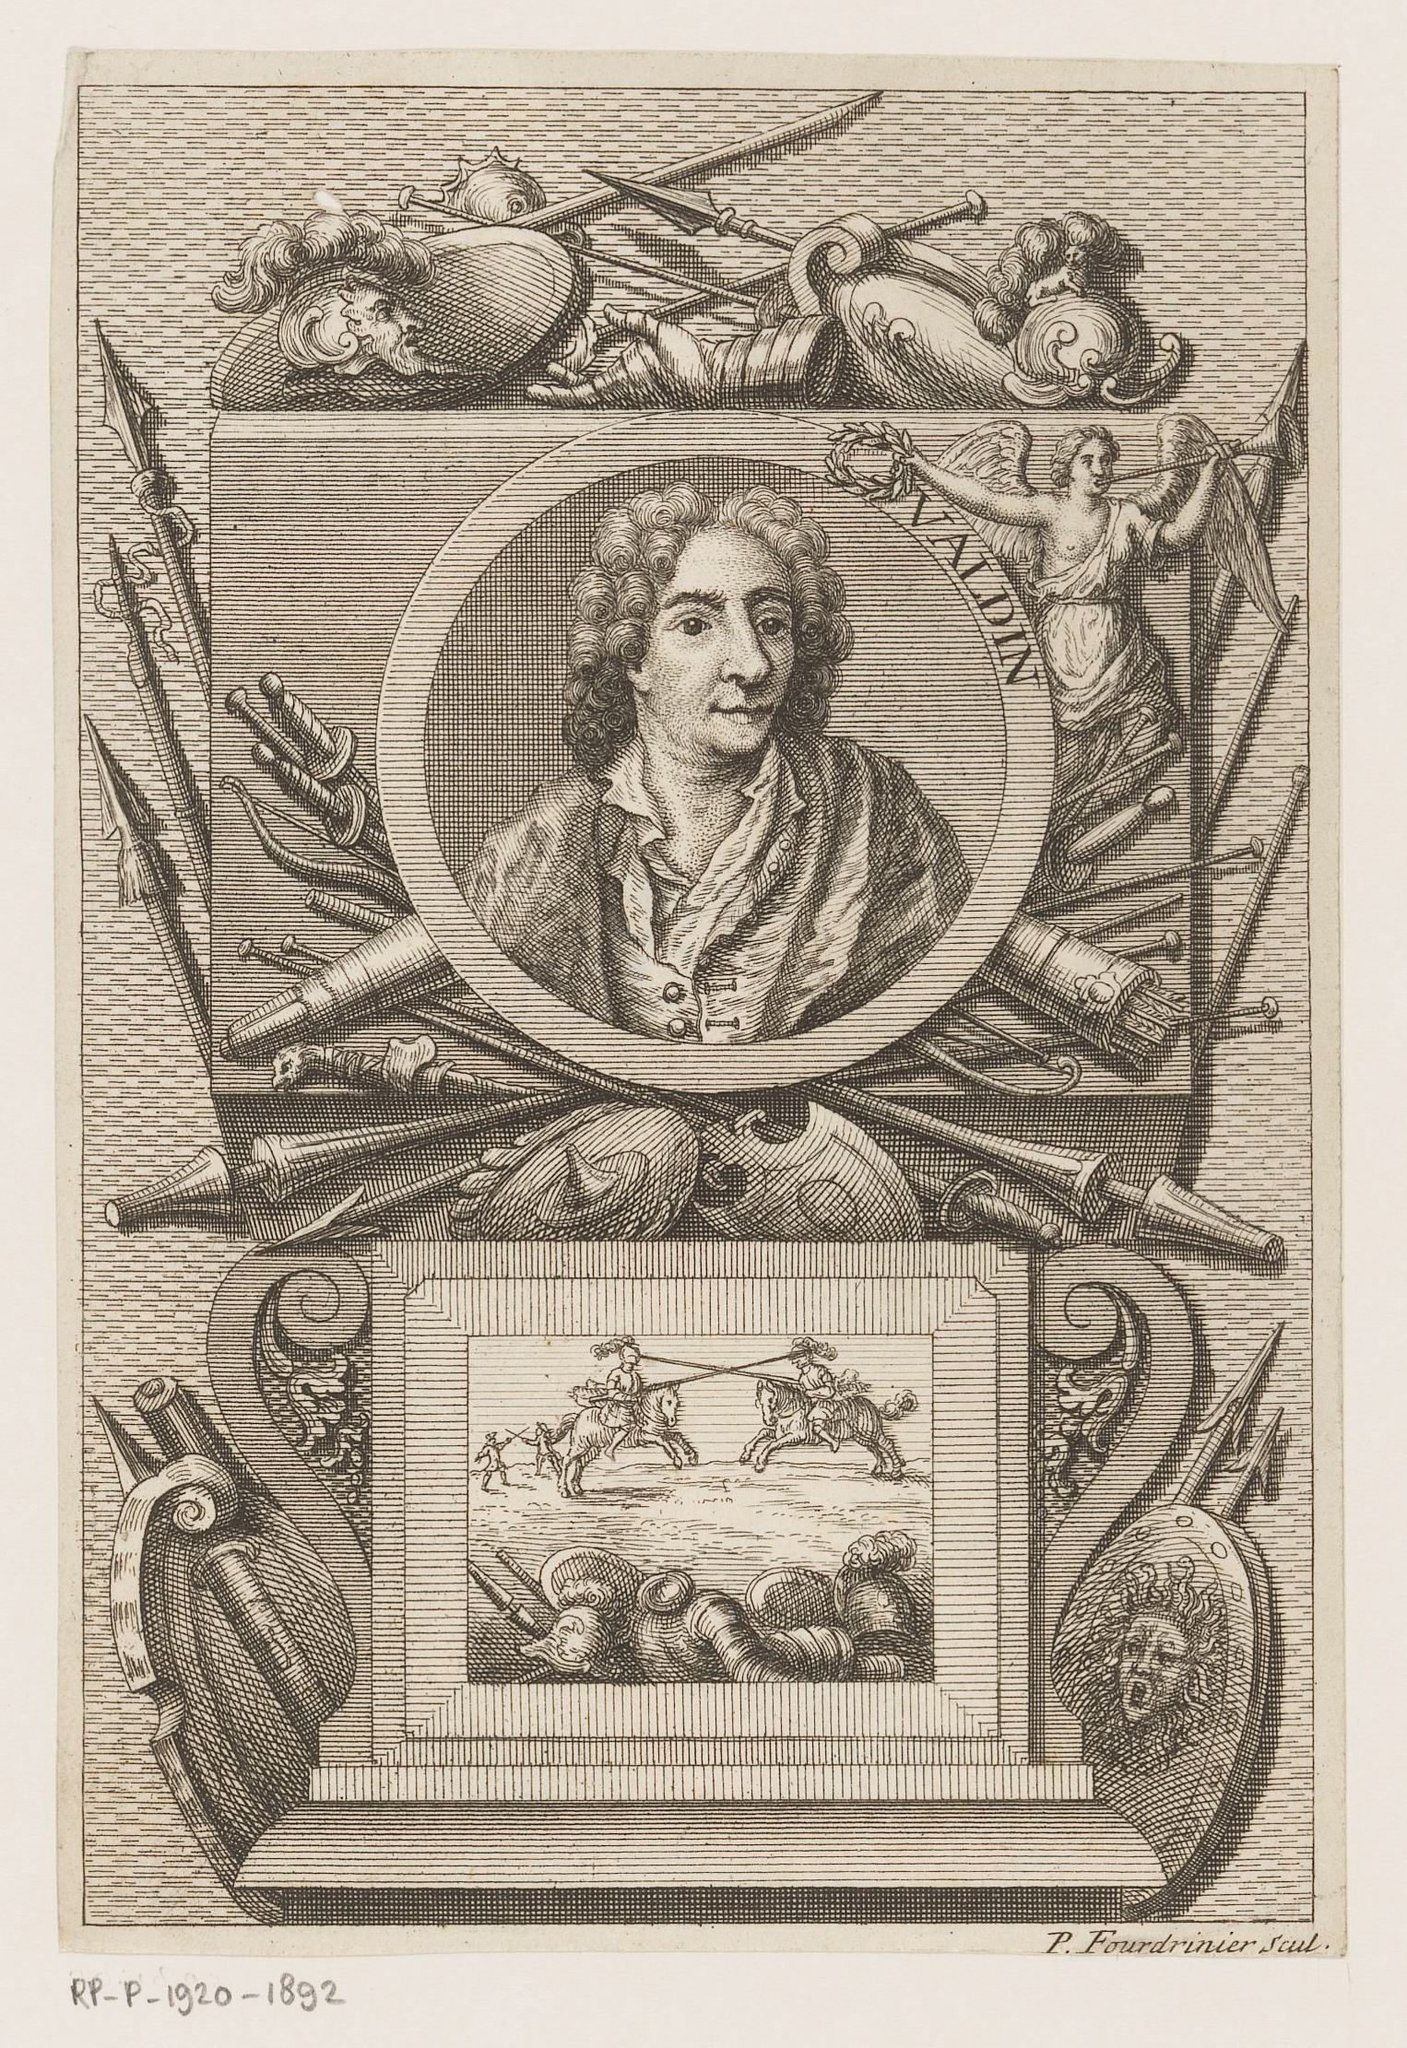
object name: print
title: Portret van een onbekende man, mogelijk Valdin, in een cartouche met wapens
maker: pierre fourdrinier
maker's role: print maker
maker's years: 1715-1763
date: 1725-1763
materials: paper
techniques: engraving, etching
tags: historical persons, weapons, ornament ~ cartouche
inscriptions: collector's mark: Lugt 2228